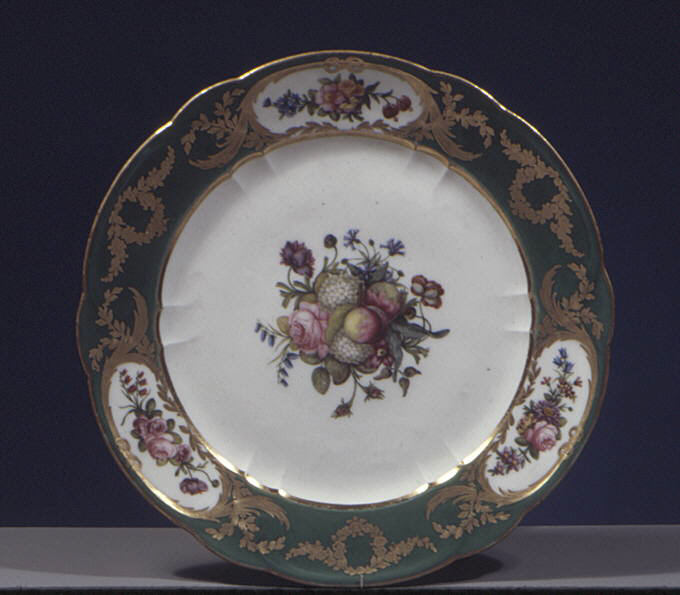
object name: plate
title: Plate (part of a service)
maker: sèvres manufactory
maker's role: manufactory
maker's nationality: french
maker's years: 1740-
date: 1775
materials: soft paste porcelain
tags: fruit,flowers